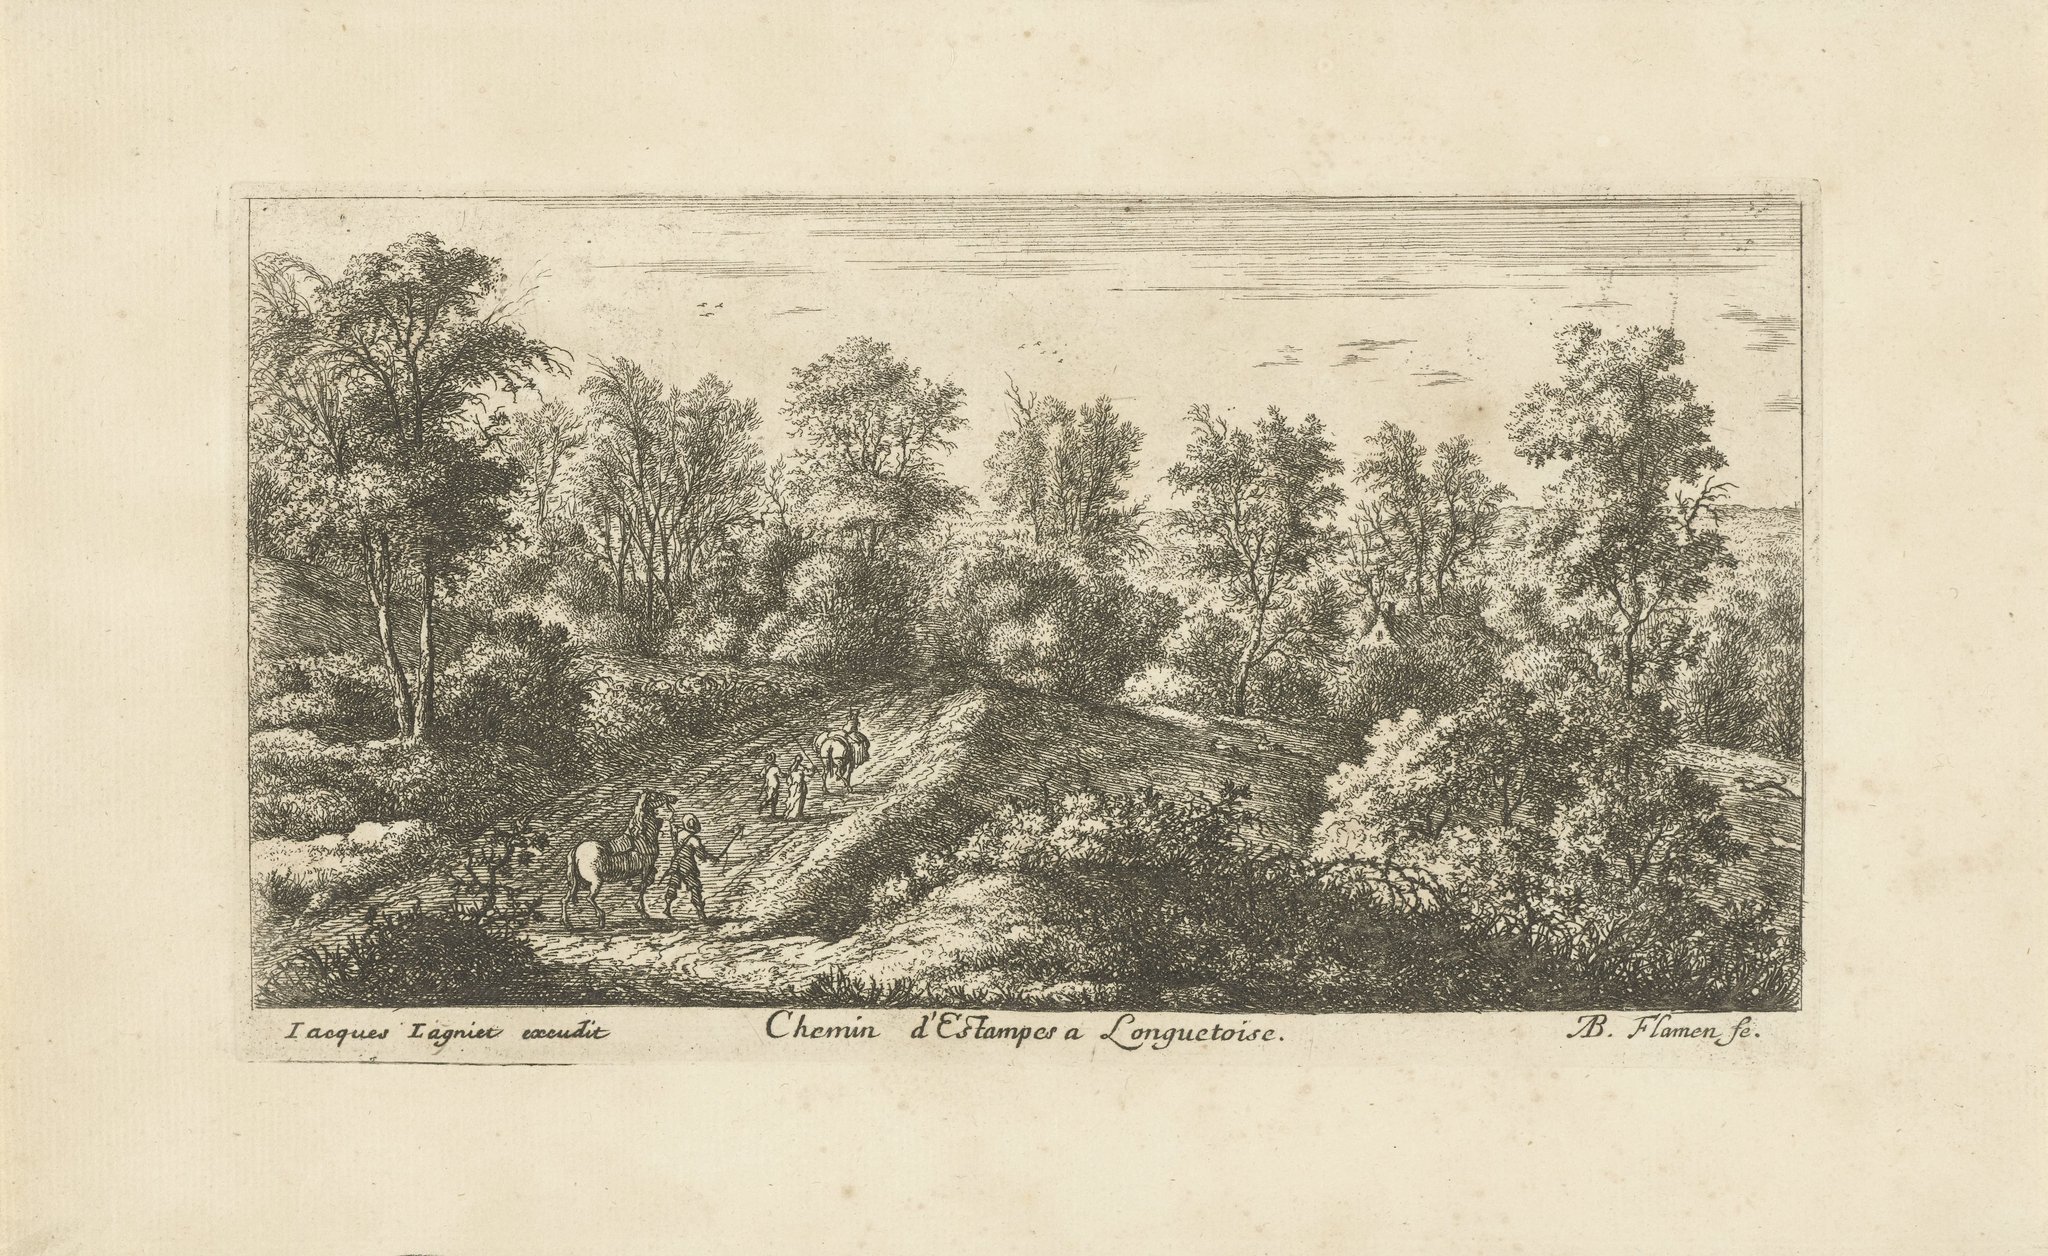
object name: print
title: Chemin d'Estampes a Longuetoise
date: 1648-1672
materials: paper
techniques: etching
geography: paris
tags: forest path or lane (+ landscape with figures, staffage)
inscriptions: collector's mark: Lugt 2228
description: Gezicht op een bosachtig landschap met een pad waarop drie personen, een paard en een ezel lopen.